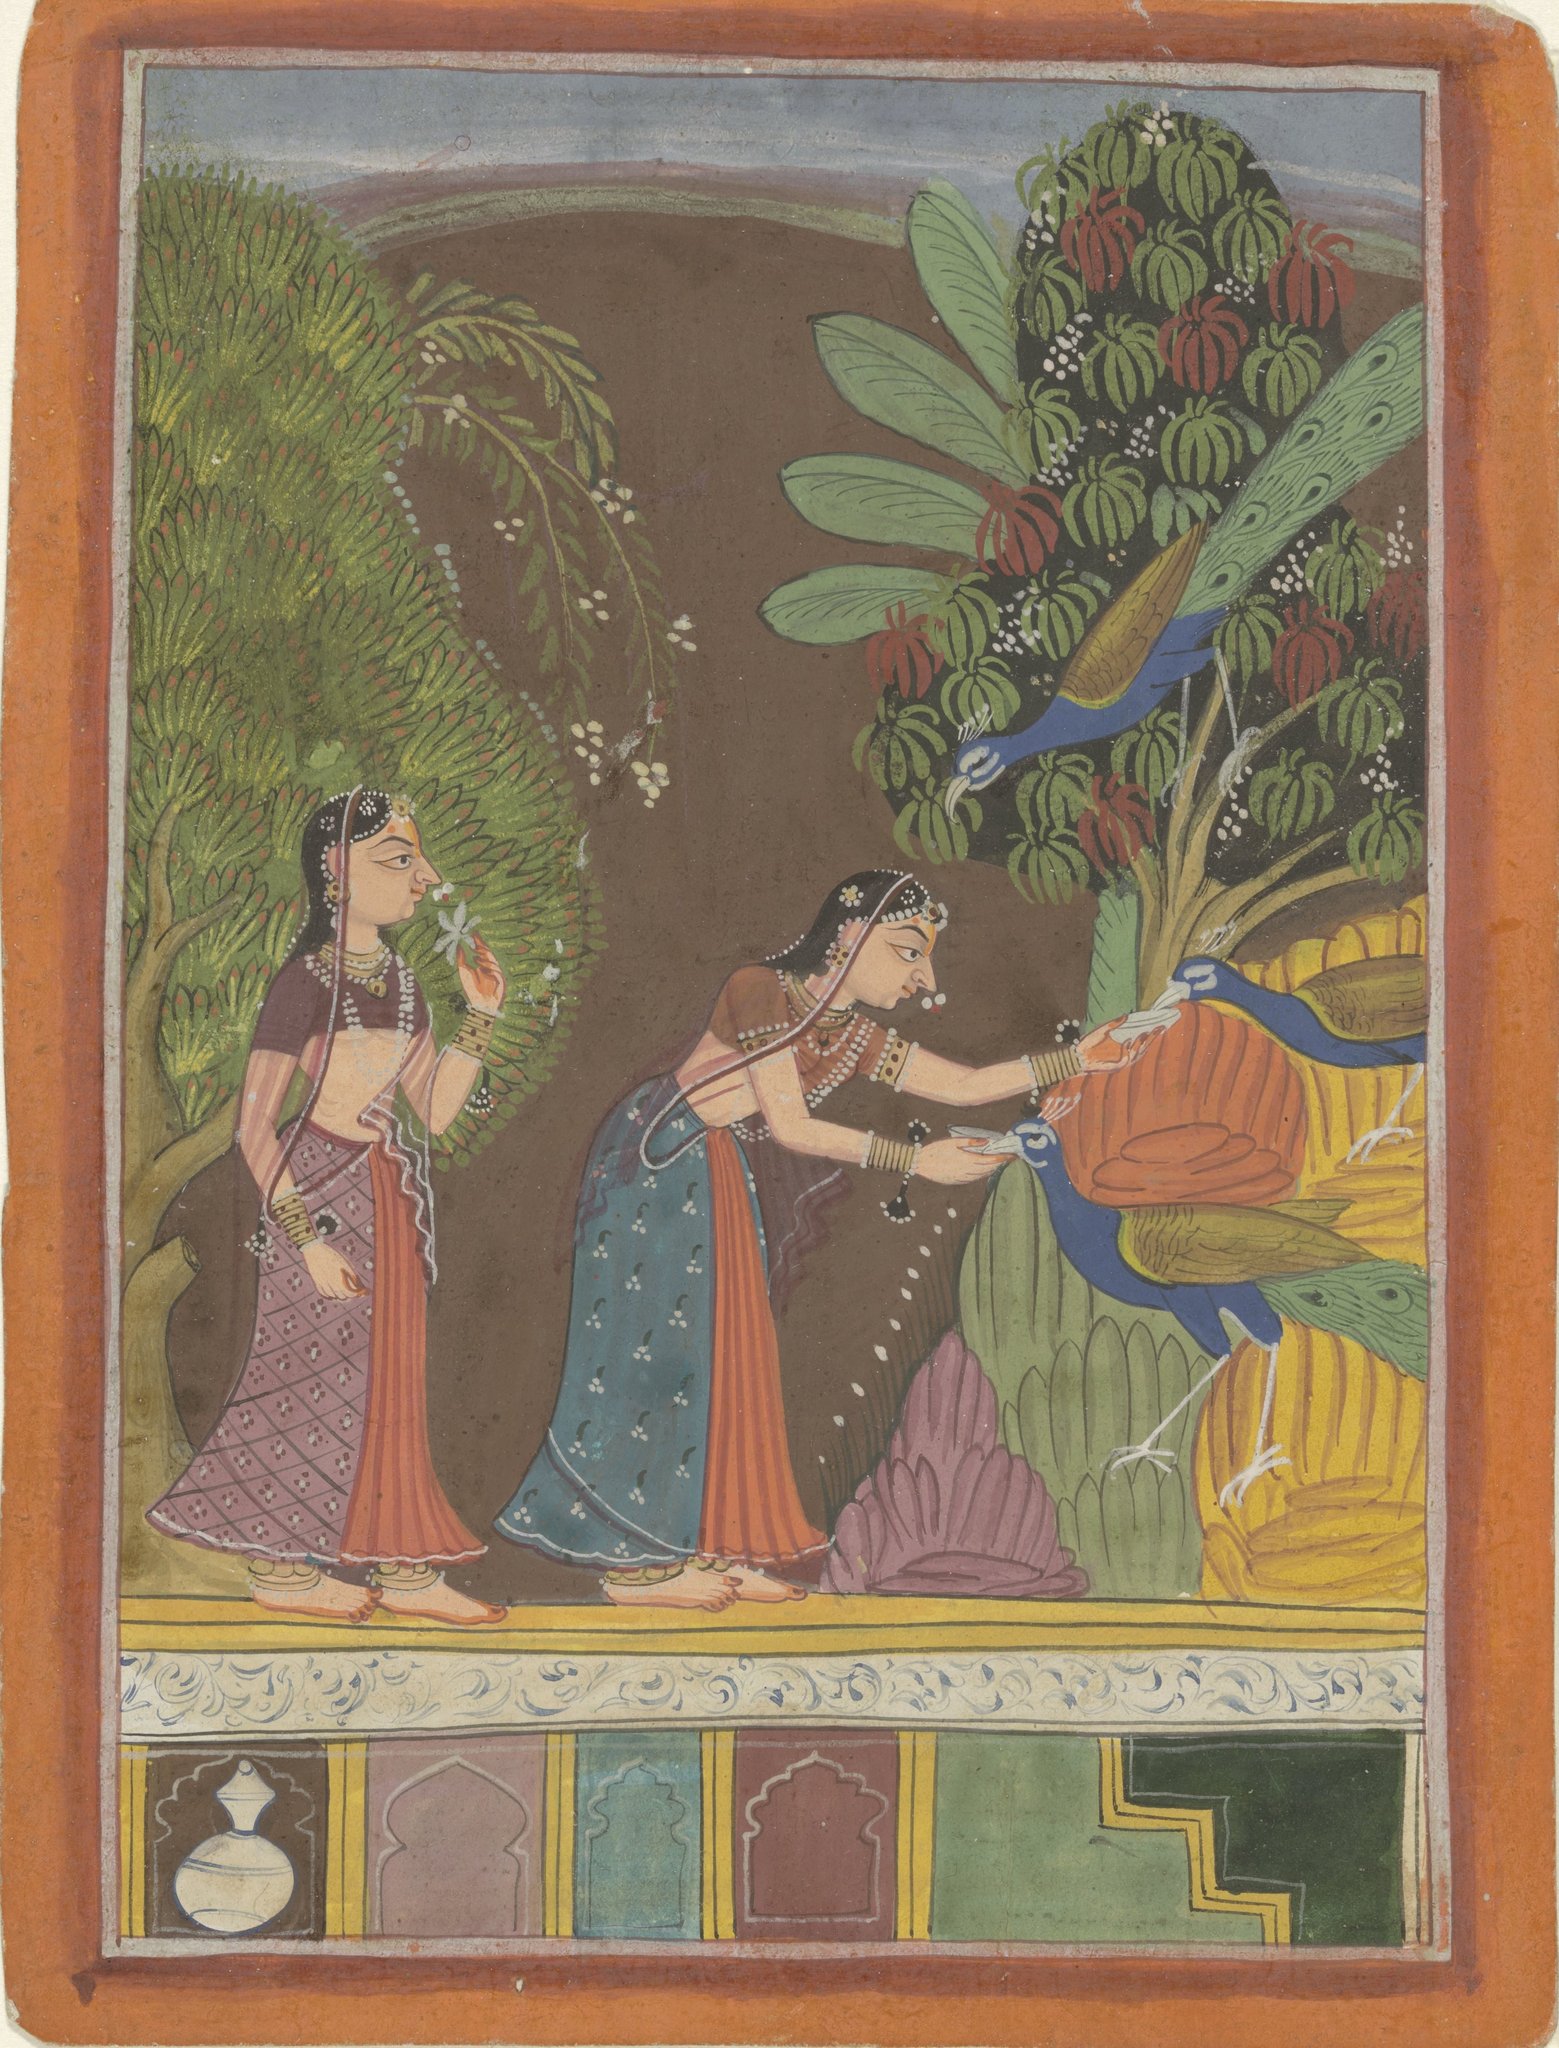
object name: indian miniature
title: Kamod ragini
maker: Anonymous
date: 1690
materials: paper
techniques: brush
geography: sirohi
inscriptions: inscription: ‘.’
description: Twee vrouwen staan in een donker getint landschap met bomen en rotsen, de vrouw in het midden voert twee pauwen met vruchten van de boom; onderaan een randpatroon van geometrische vormen. Rond de voorstelling een smalle witte en een lila rand en een brede oranjerode rand met afgeronde hoeken.